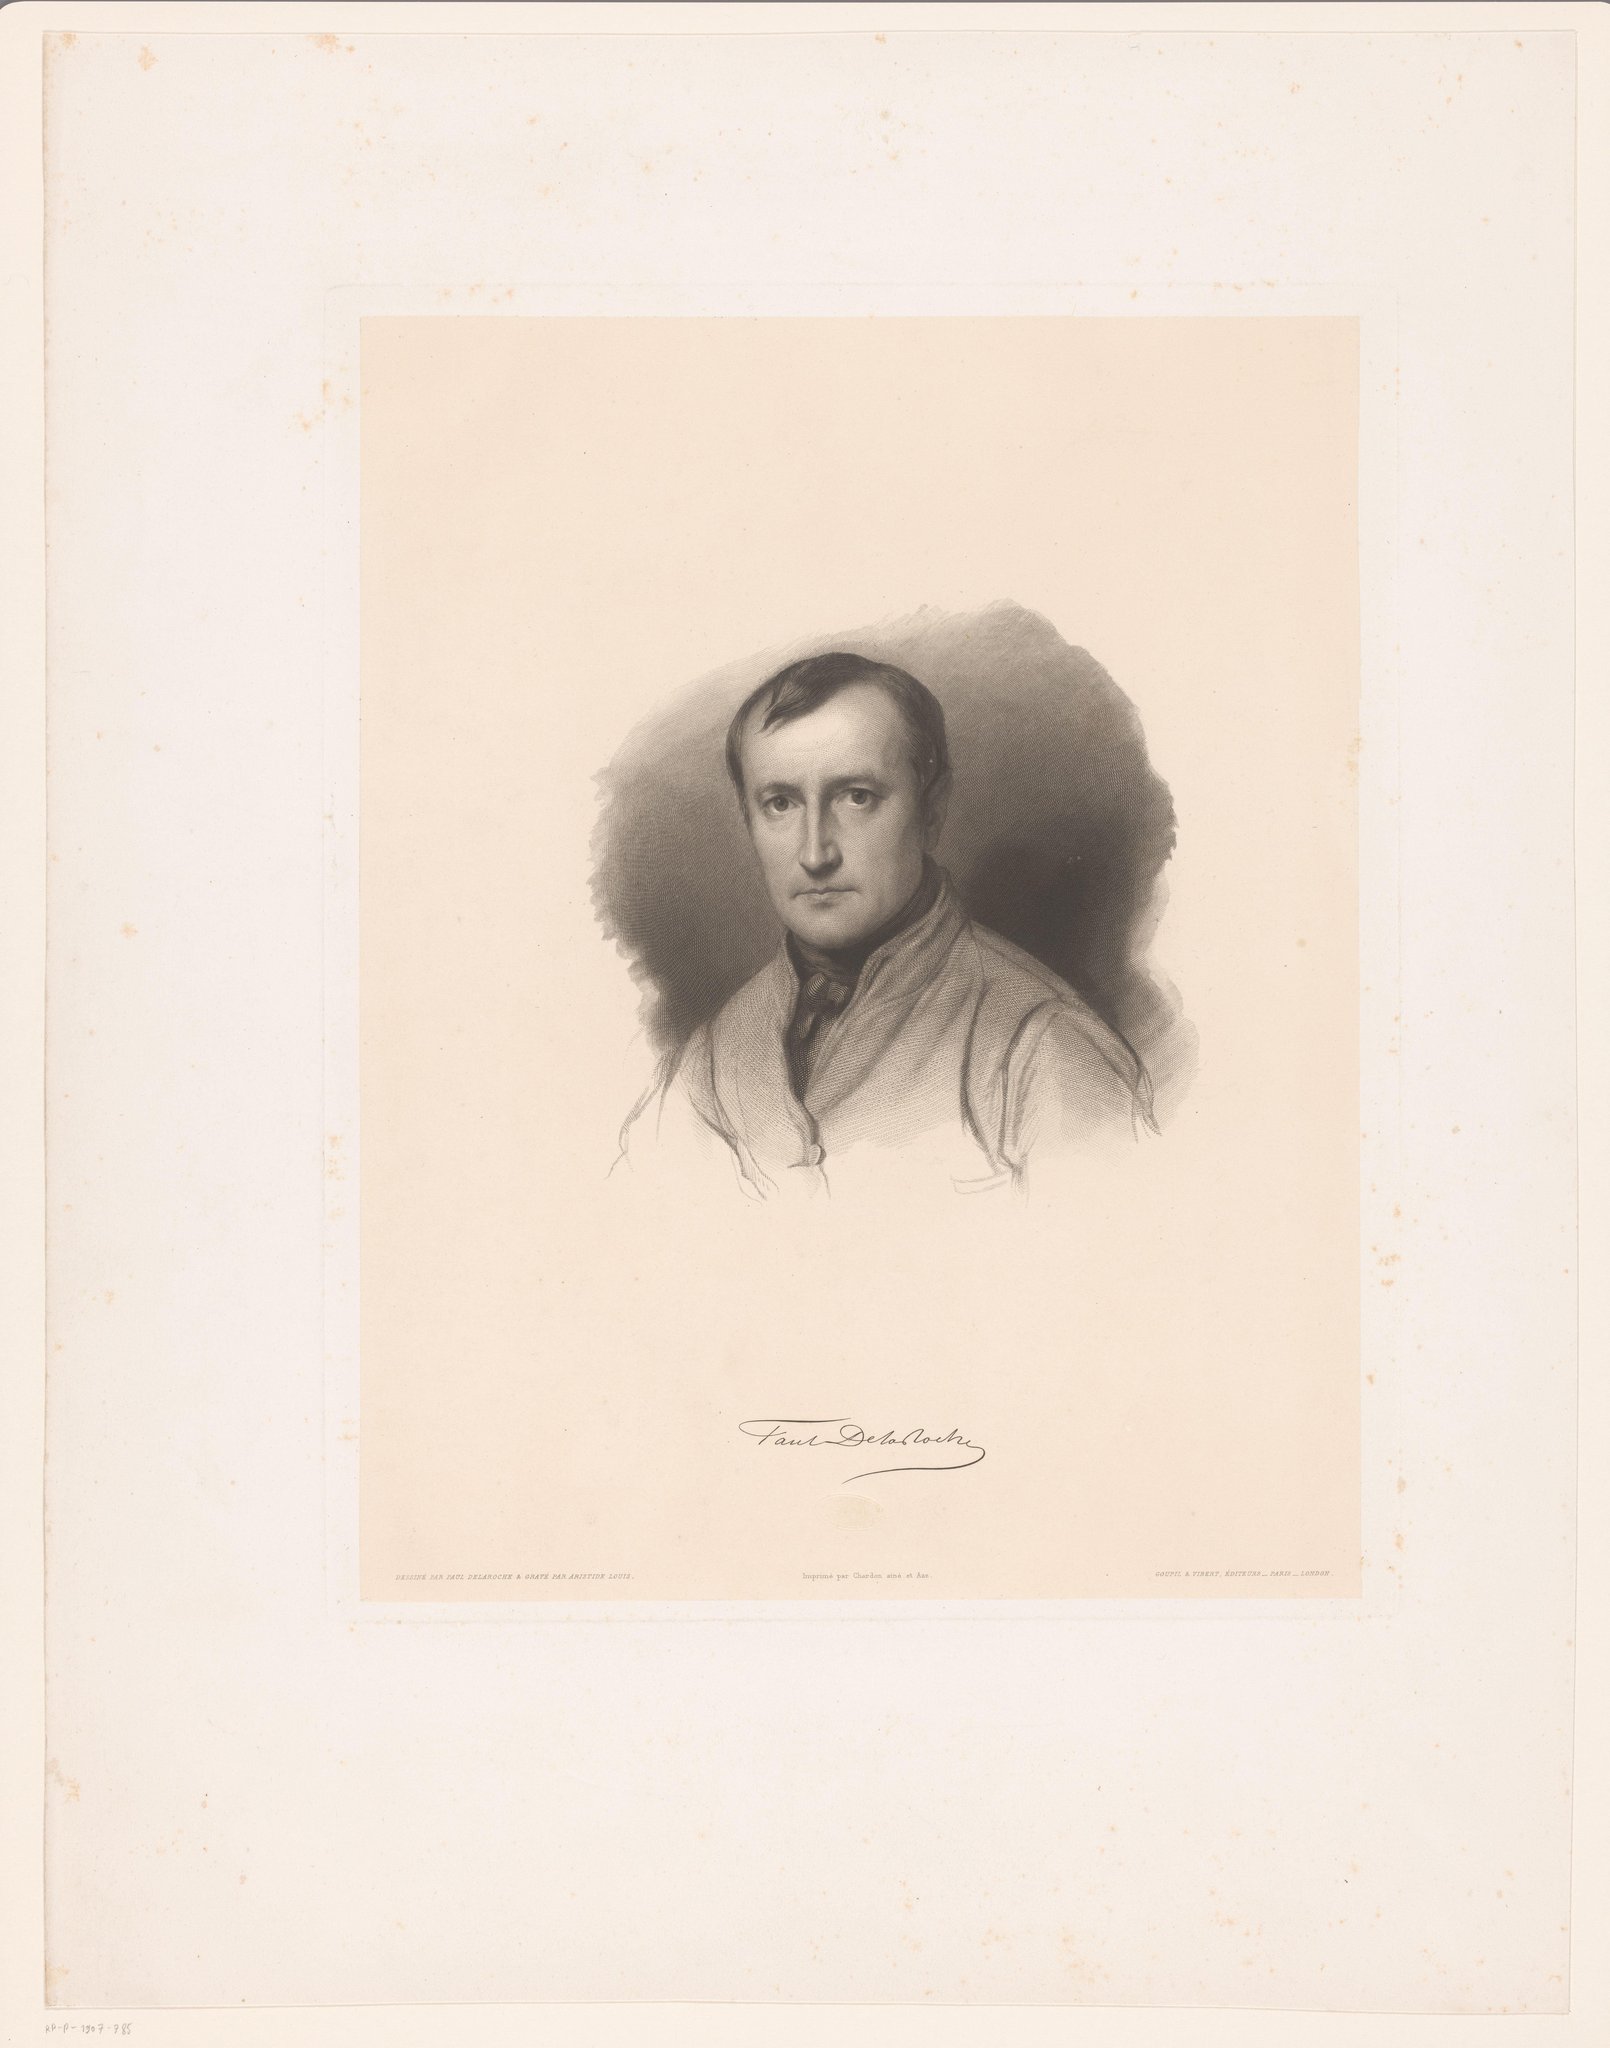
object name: print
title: Paul Delaroche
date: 1845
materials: paper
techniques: engraving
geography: london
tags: paris, painter, draughtsman, sculptor, paul delaroche, historical persons, portrait, self-portrait of painter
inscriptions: collector's mark: Lugt 2228, check stamp: Lugt 5003